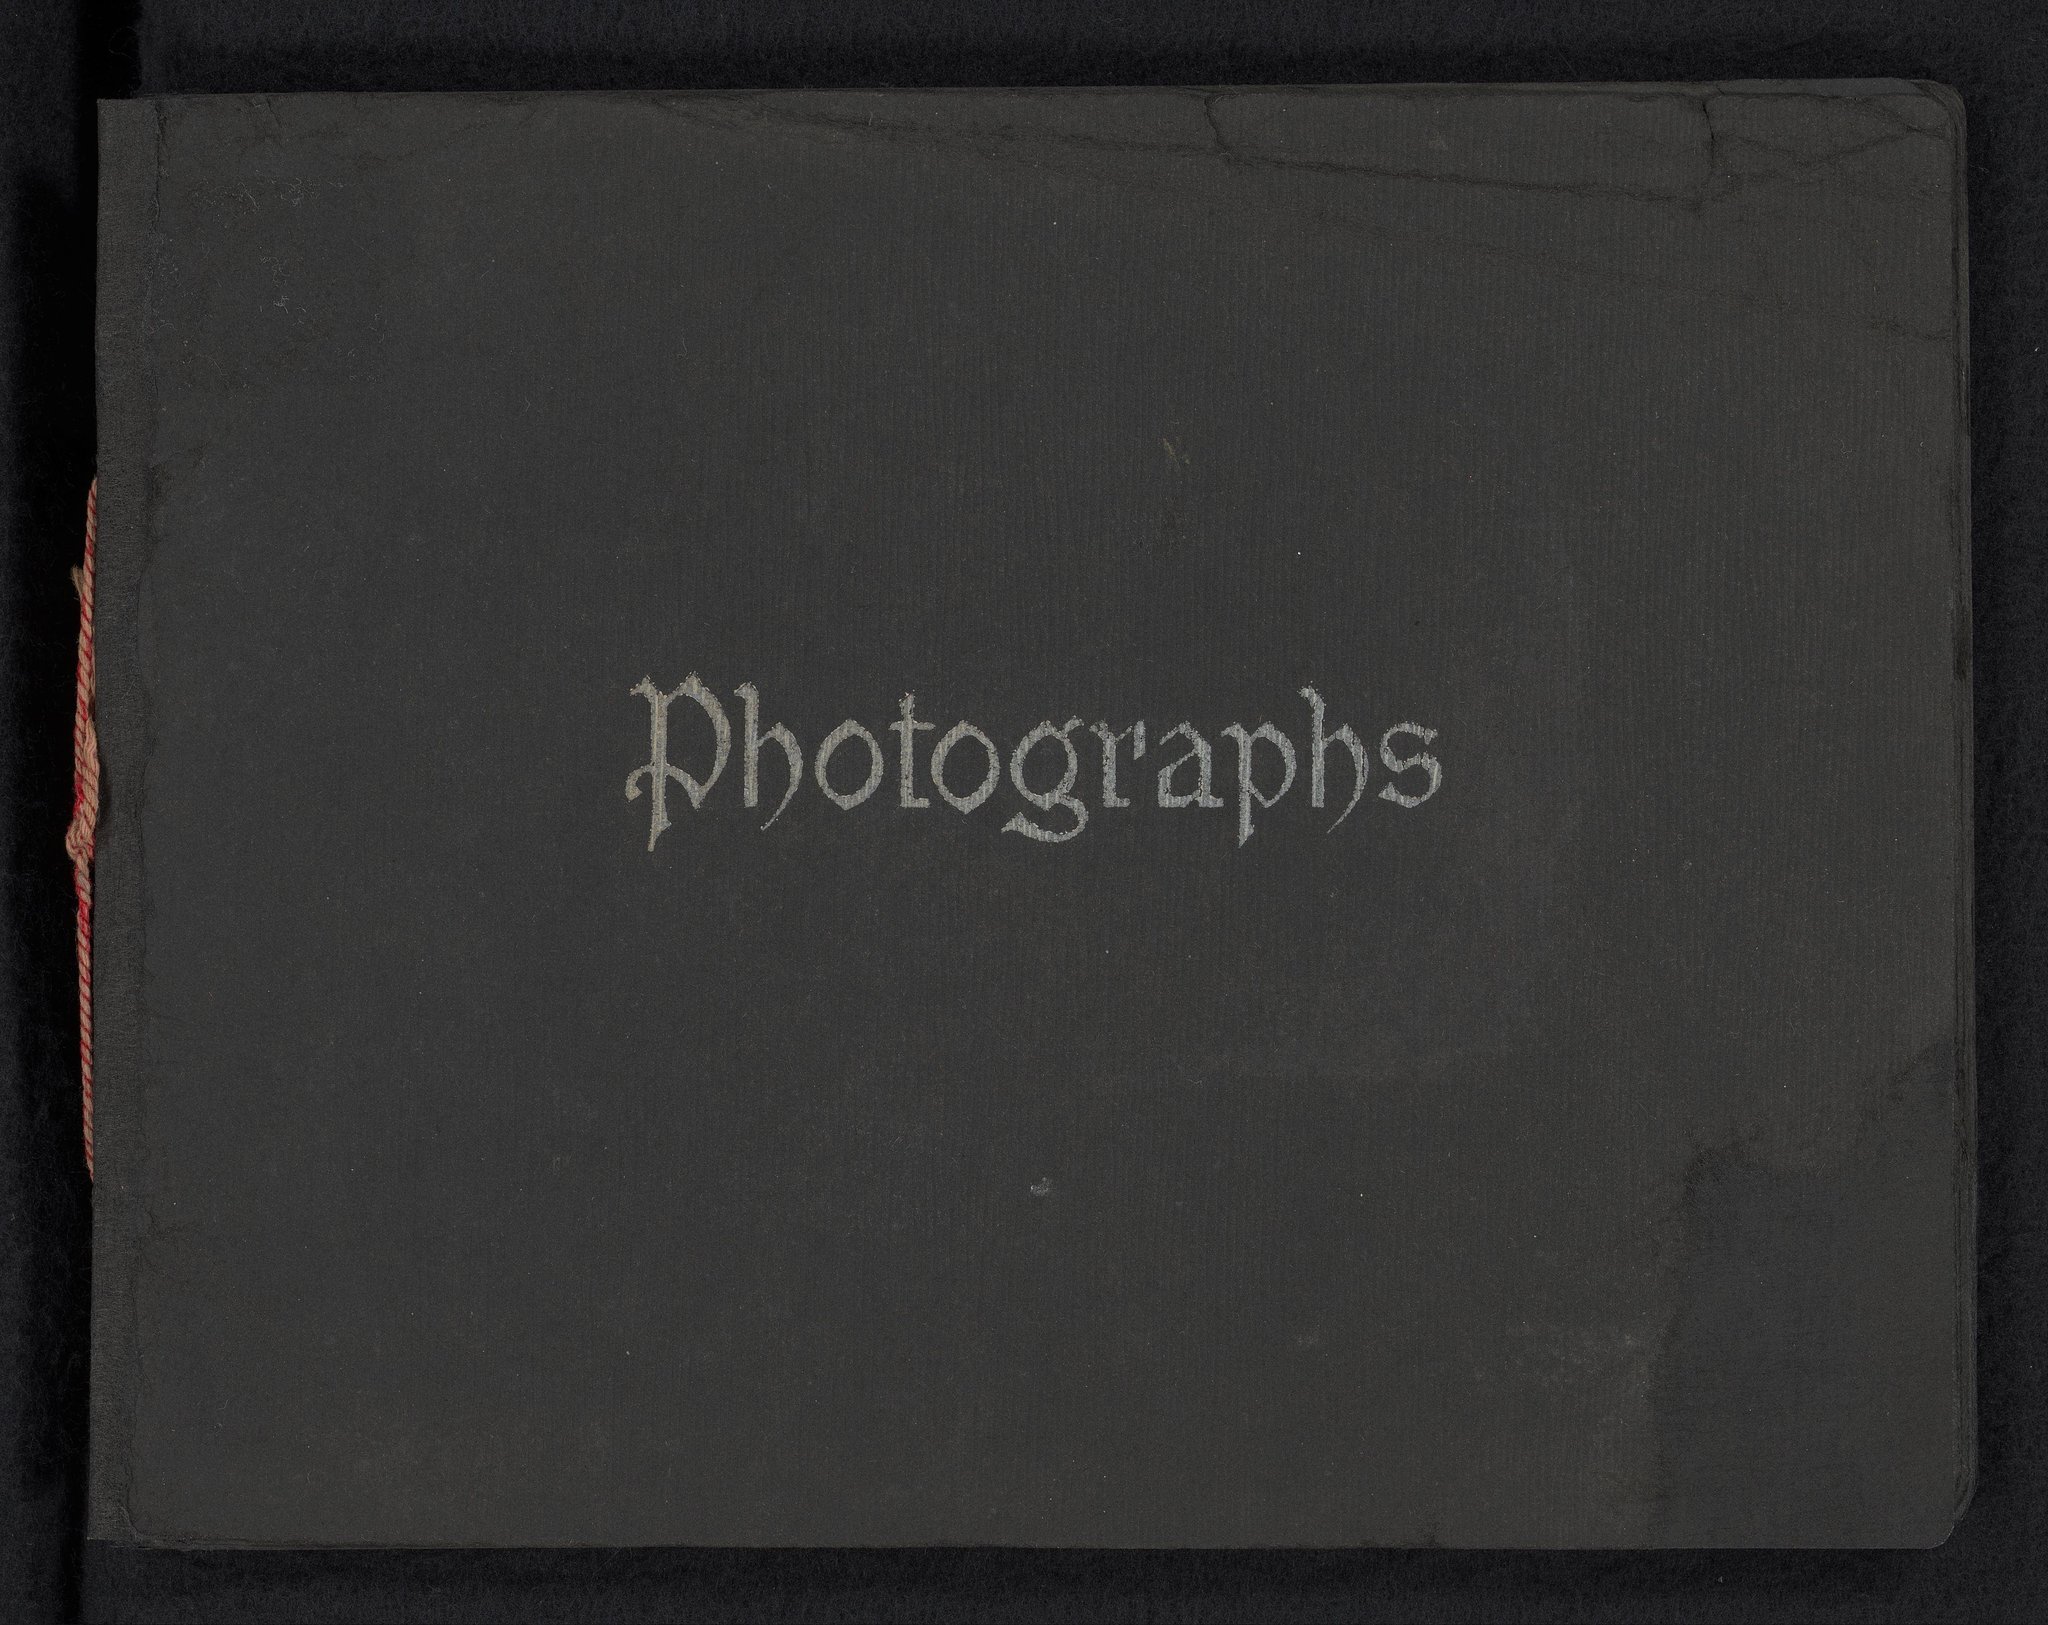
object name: photograph album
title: Album van Leidse studente bij Kagerplassen en strand van Scheveningen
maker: Anonymous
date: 1920-1925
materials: paper, photographic support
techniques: collodion silver print, gelatin silver print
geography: south holland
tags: adult woman, adult man, historical persons, student life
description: Album met 29 pagina's, waarvan 13 gevuld met in totaal 27 foto's, gemaakt door een onbekende Leidse studente bij o.a. de Kagerplassen en het strand bij Scheveningen.